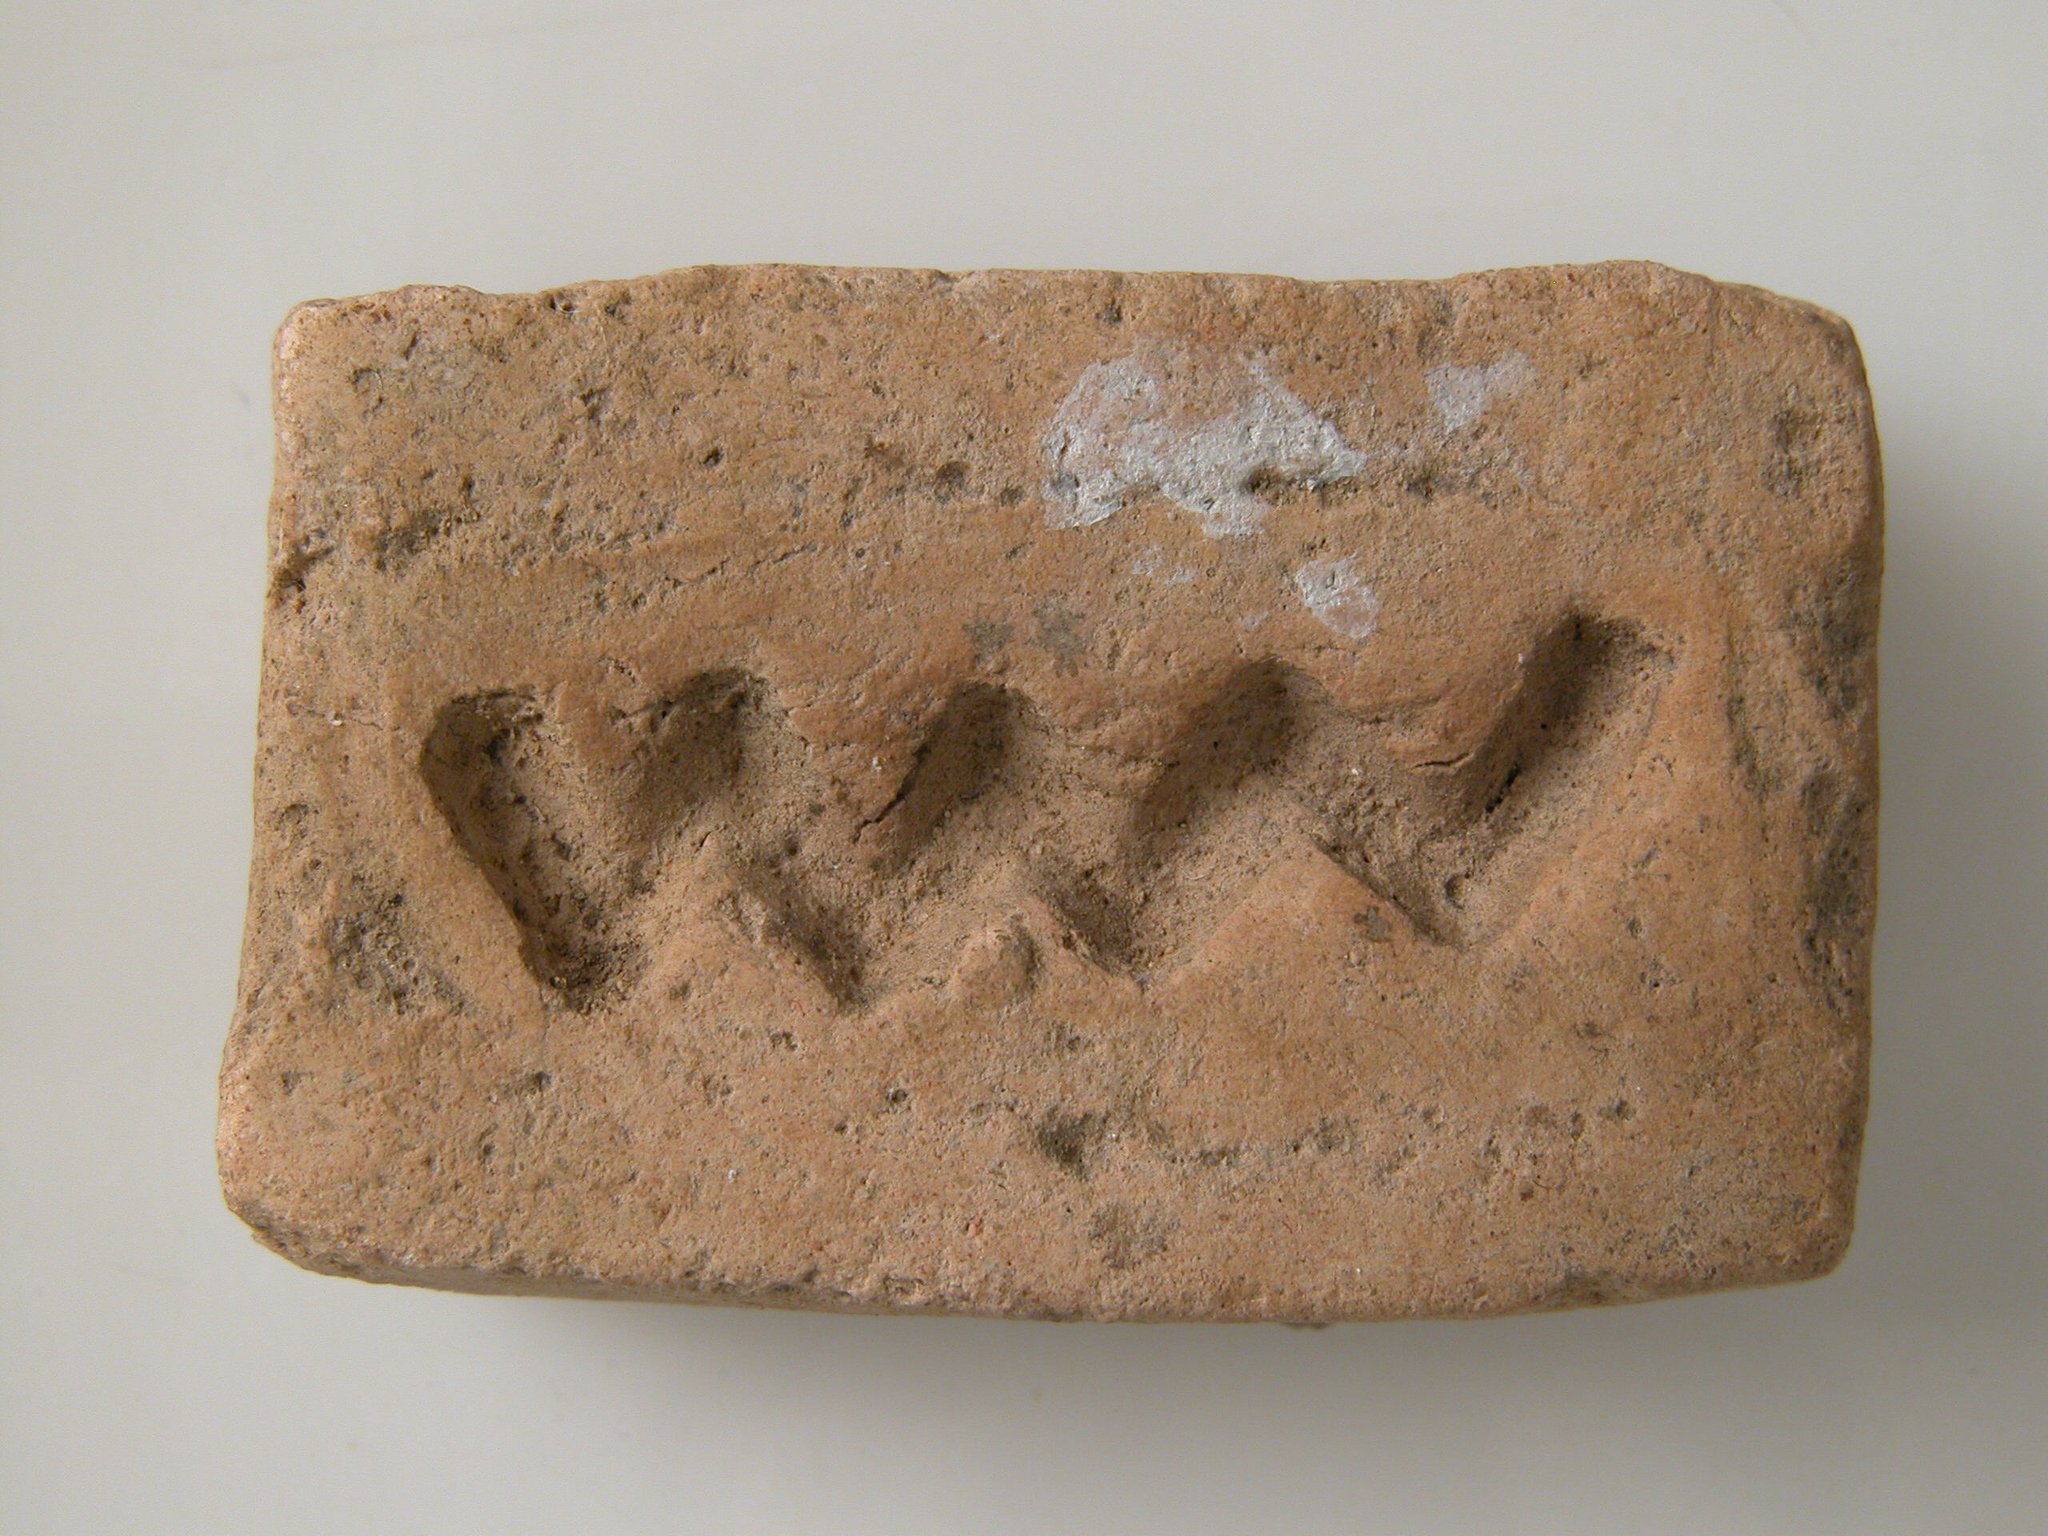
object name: impression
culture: coptic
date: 301-700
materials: earthenware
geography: egypt